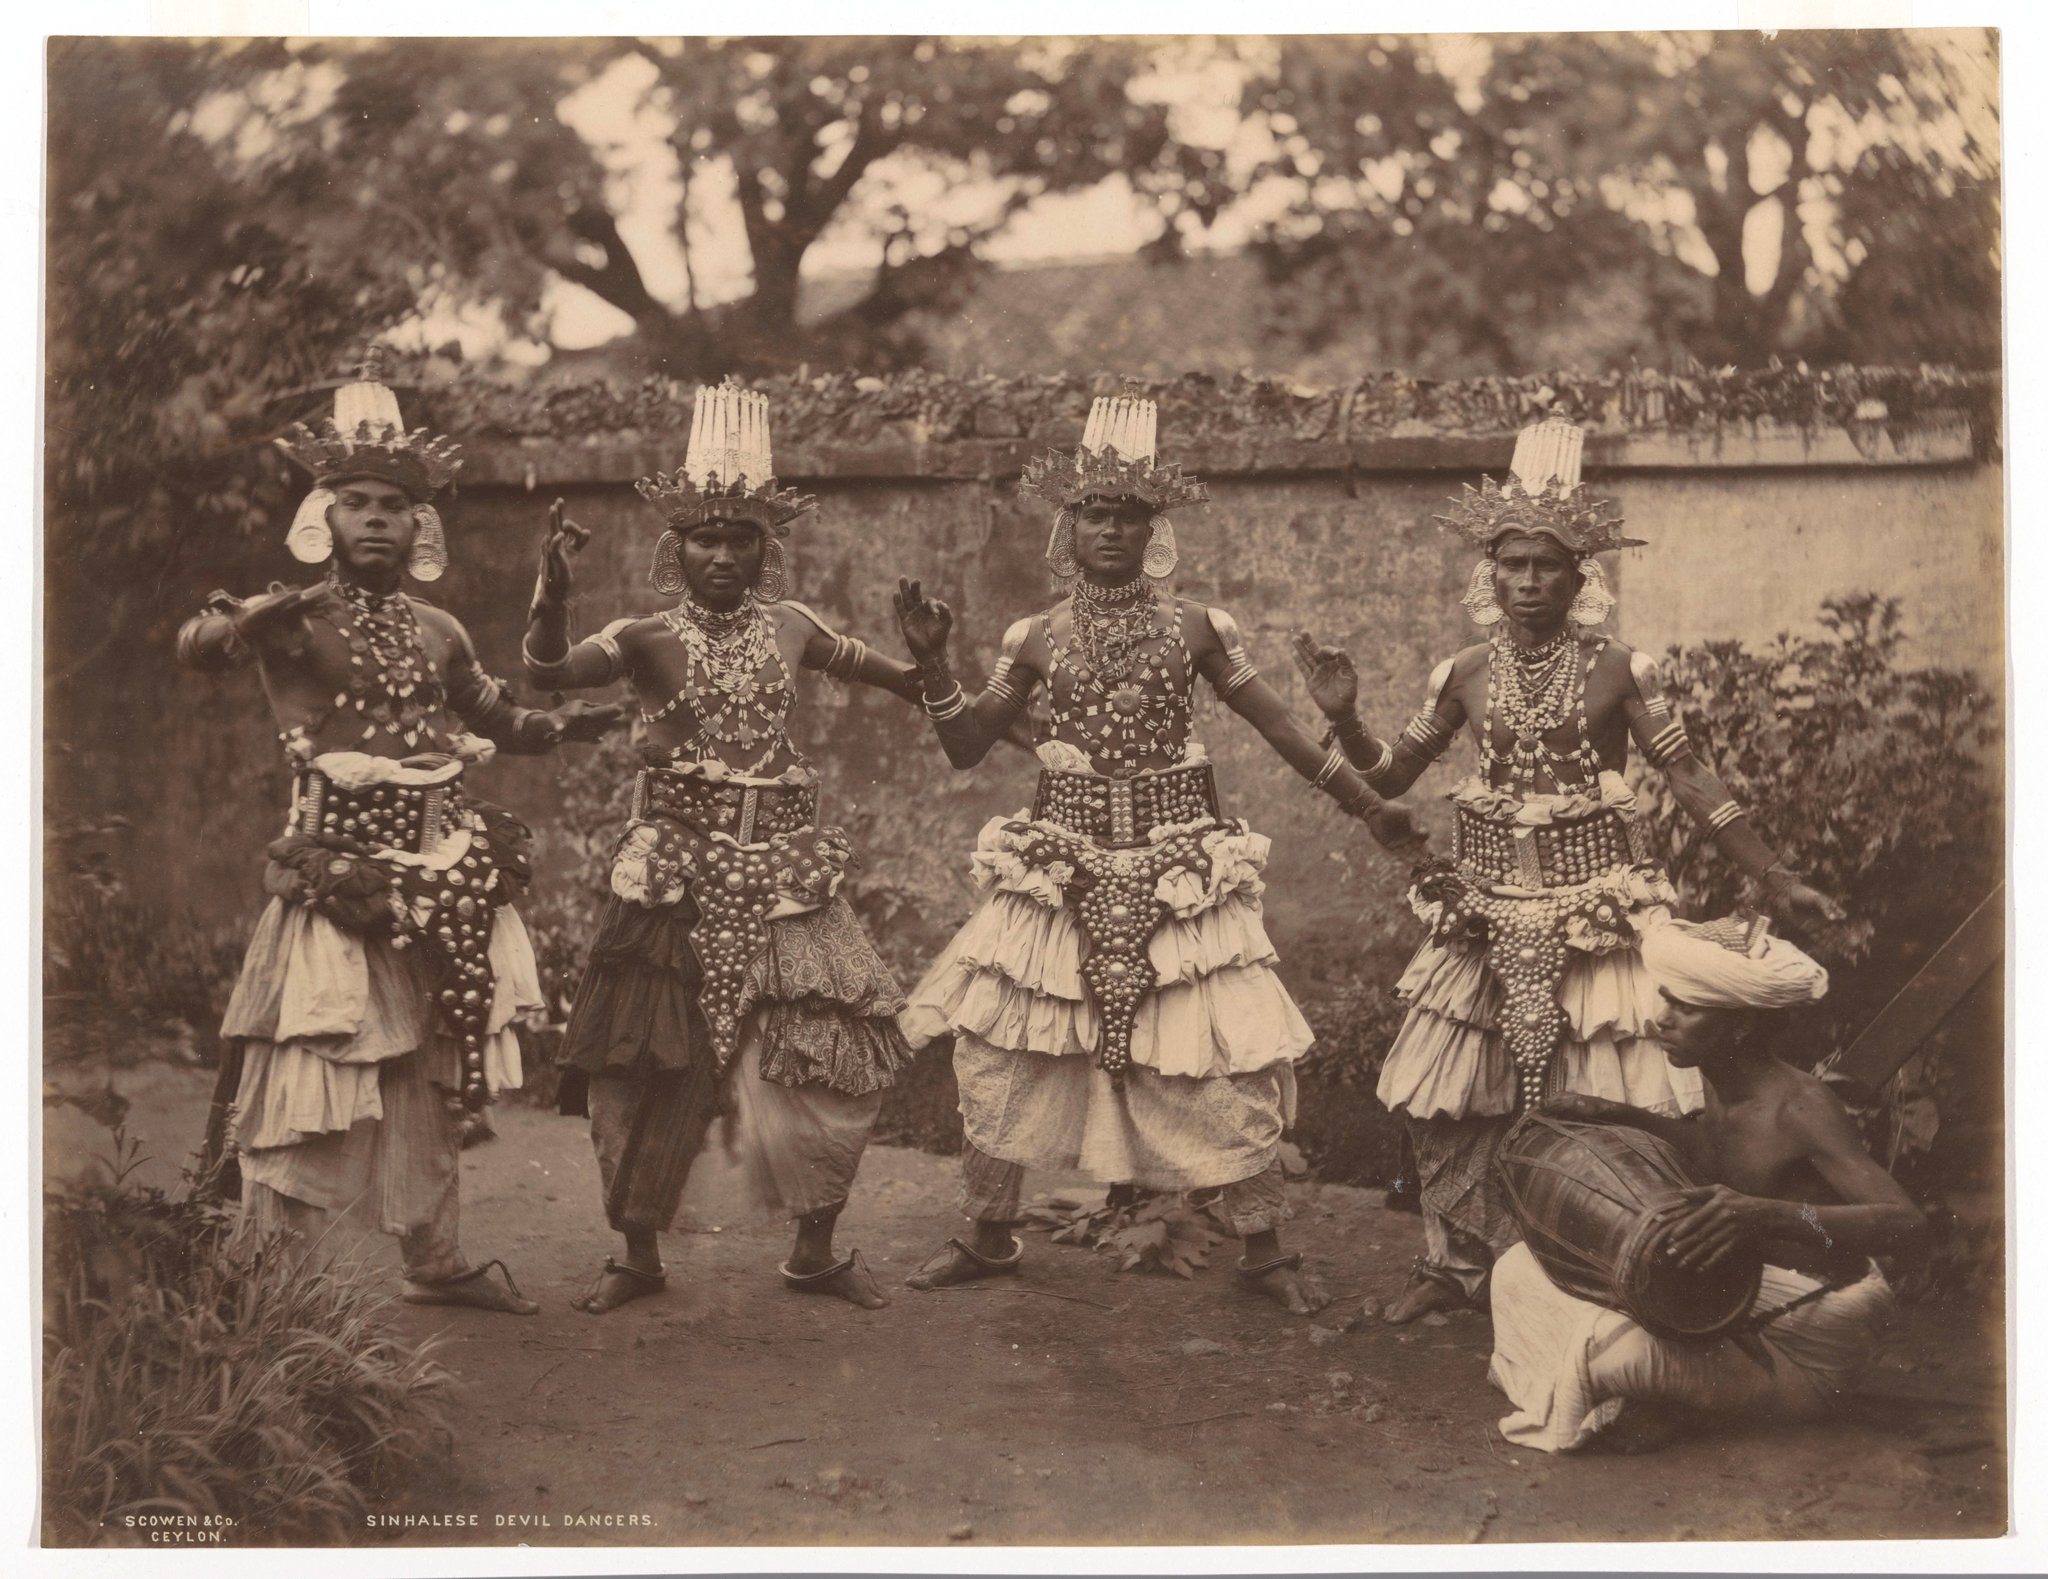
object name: photograph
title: Group of Sinhala devil dancers, Sri Lanka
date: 1876-1893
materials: paper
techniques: albumen print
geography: sri lanka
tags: ritual music and dancing ~ non-christian religions, sri lanka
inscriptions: signature: ‘Scowen & Co./ Ceylon’, title: ‘Sinhalese Devil Dancers.’, number: ‘1600/ 54’